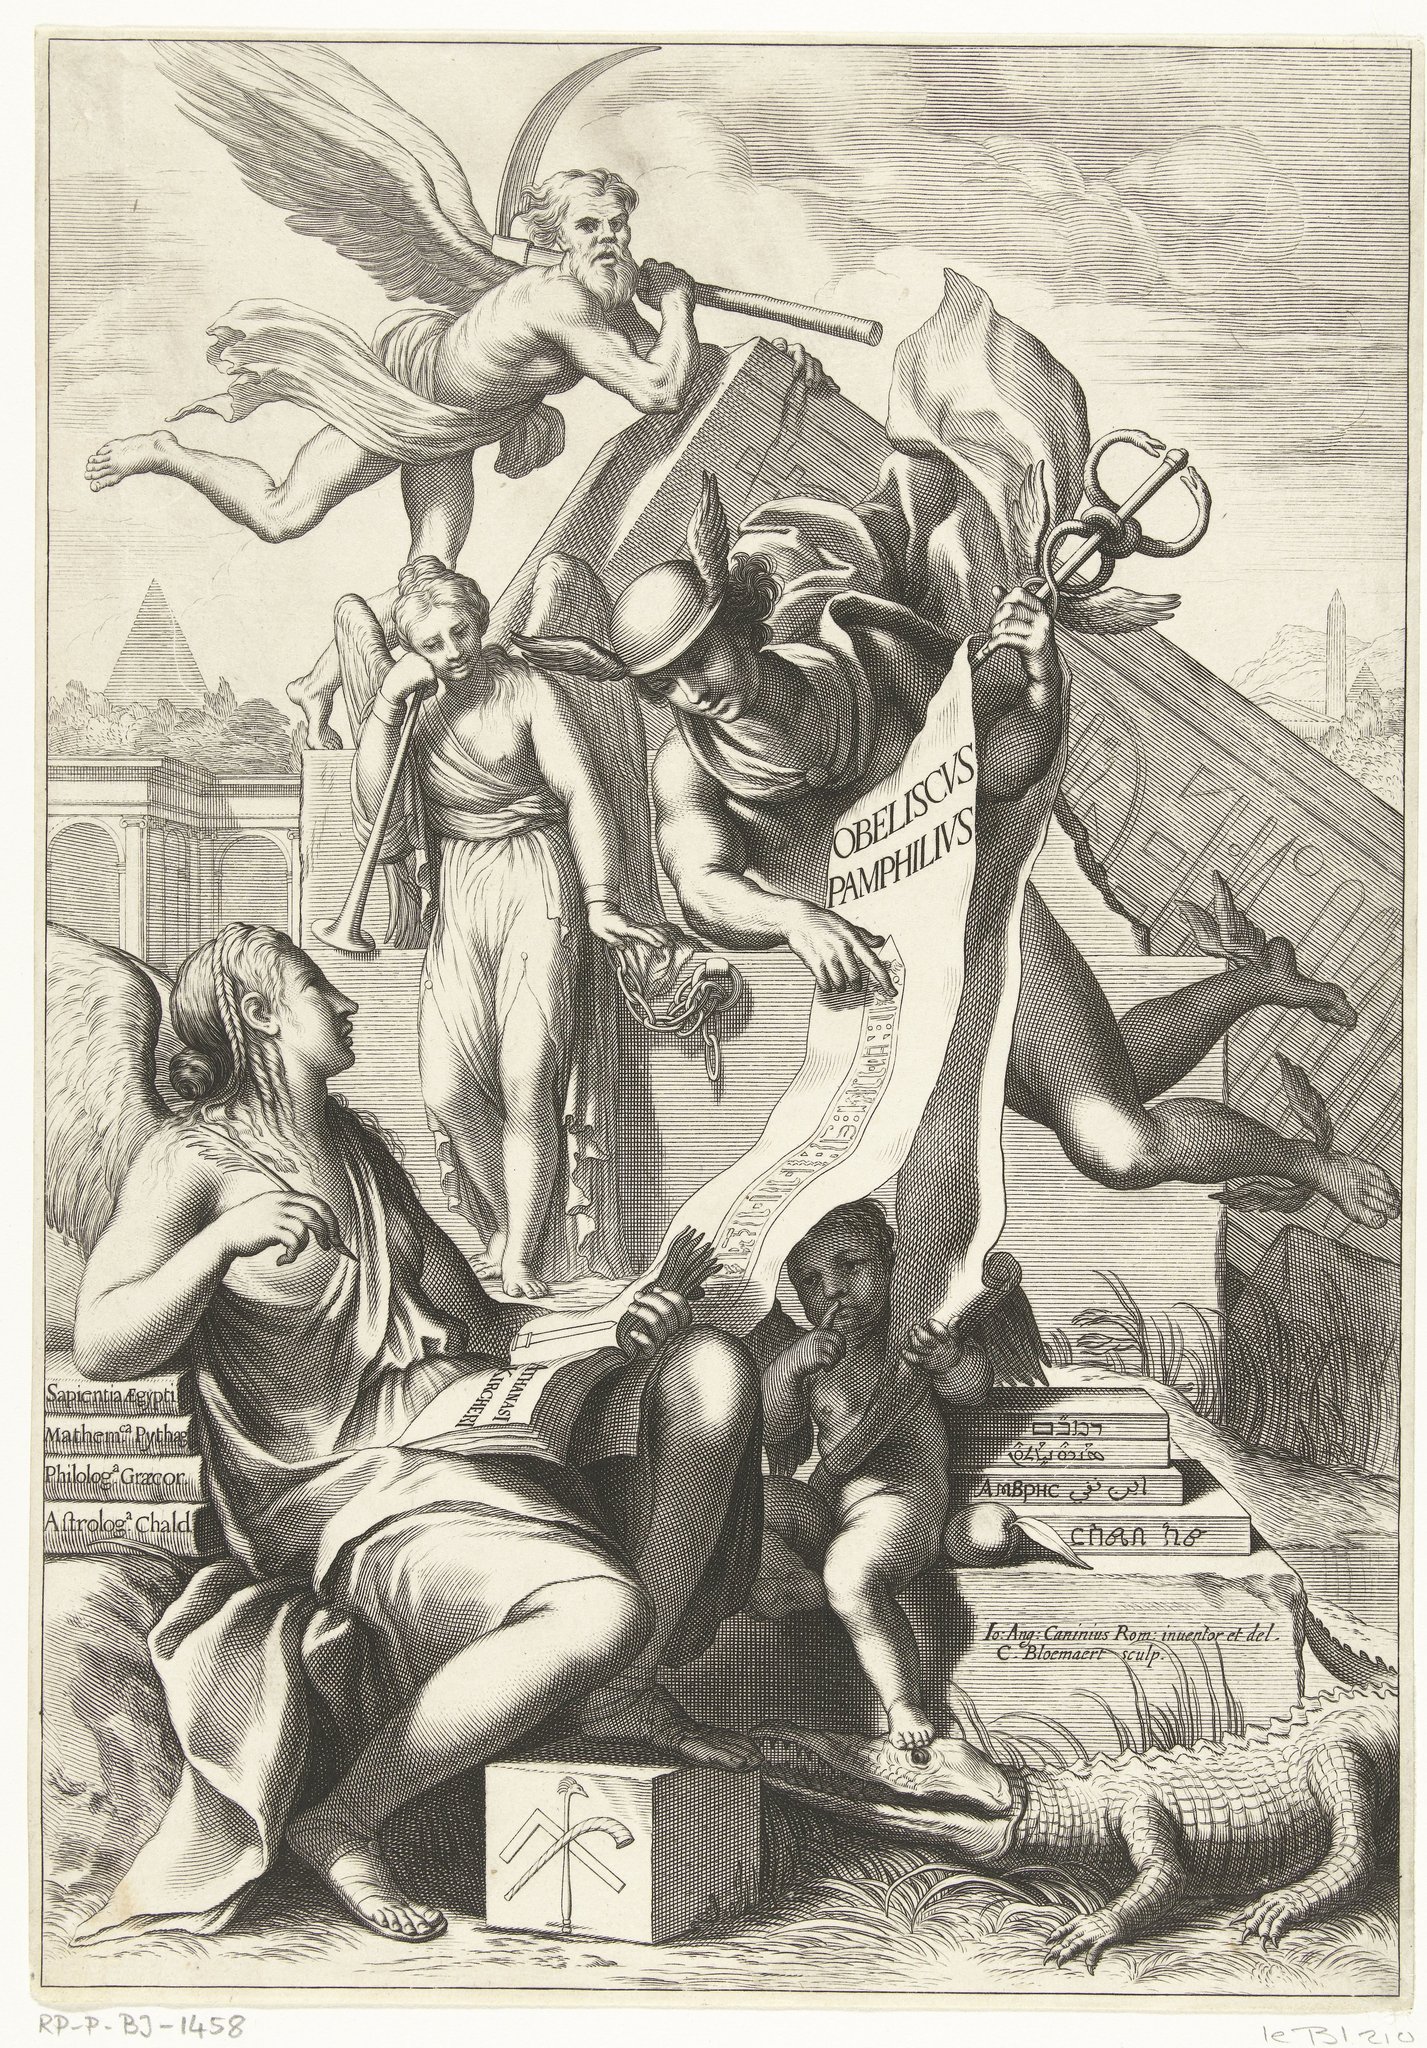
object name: print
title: Mercurius ontdekt de geschiedenis van het mysterie van Egypte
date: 1650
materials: paper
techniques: engraving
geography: rome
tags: rome, title-page, non-aggressive, friendly or neutral activities and relationships of mercury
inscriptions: collector's mark: Lugt 240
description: Mercurius komt aanzweven met gevleugelde voeten en de gevleugelde petasus. In zijn hand houdt hij de caduceus vast. Over de caduceus hangt een banier met tekst. Een jongedame, lezend in een boek, kijkt naar hem op en luistert naar zijn uitleg.